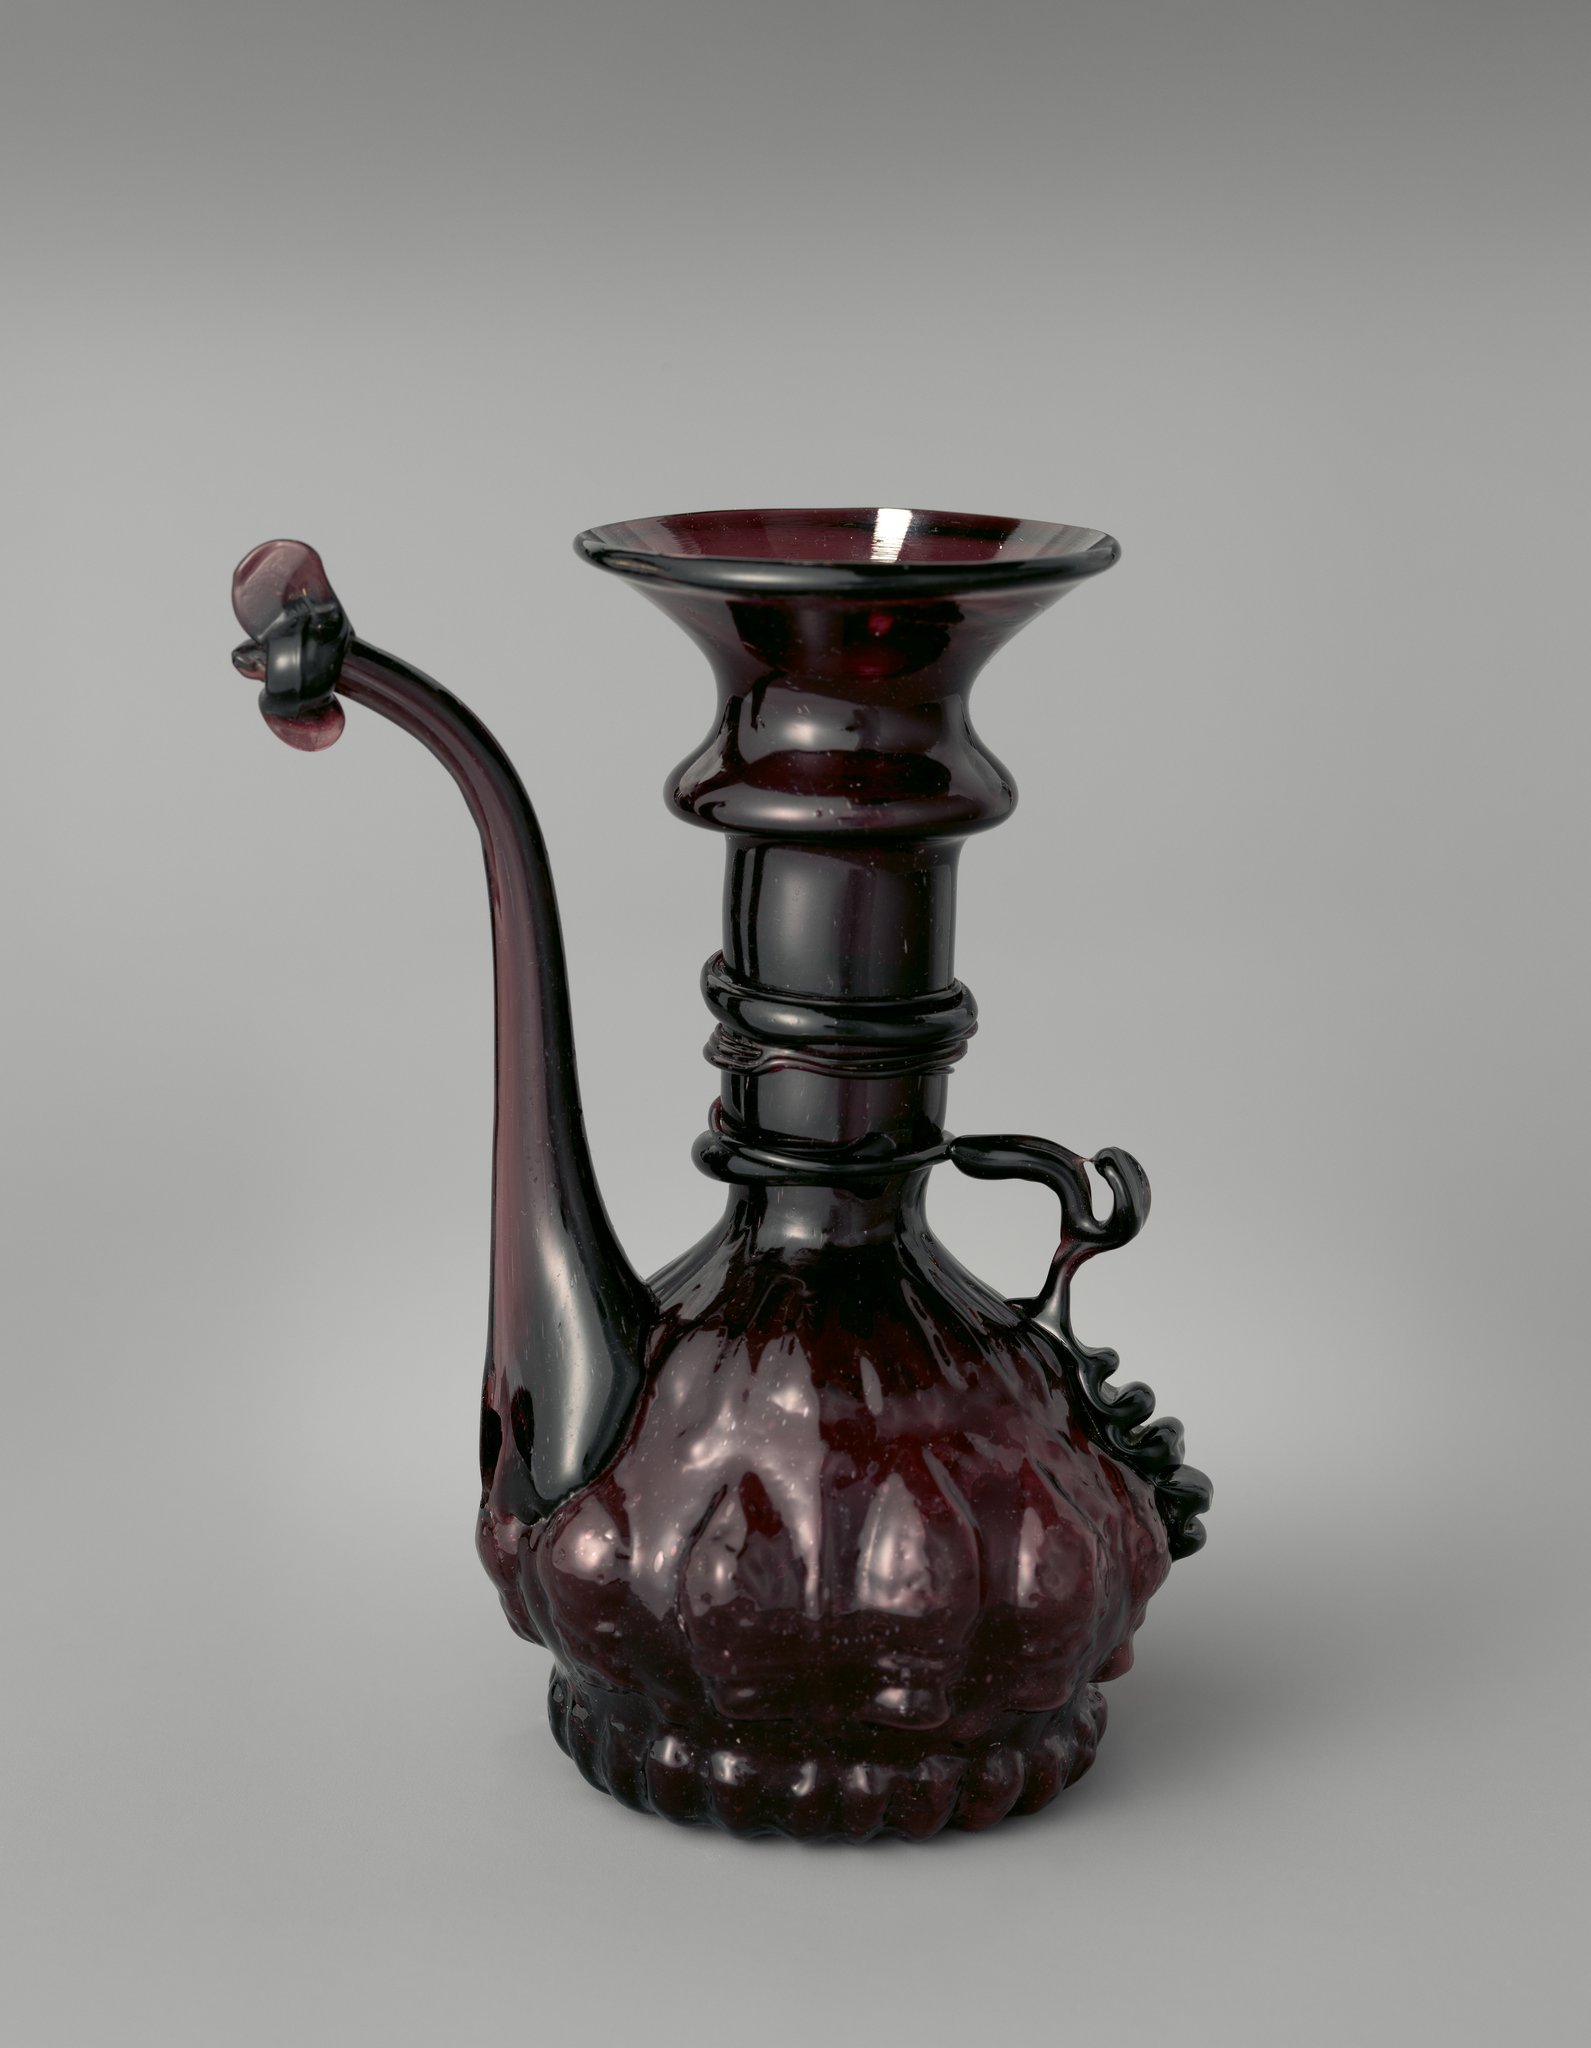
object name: ewer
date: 1801-1900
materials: glass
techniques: glassblowing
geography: iran